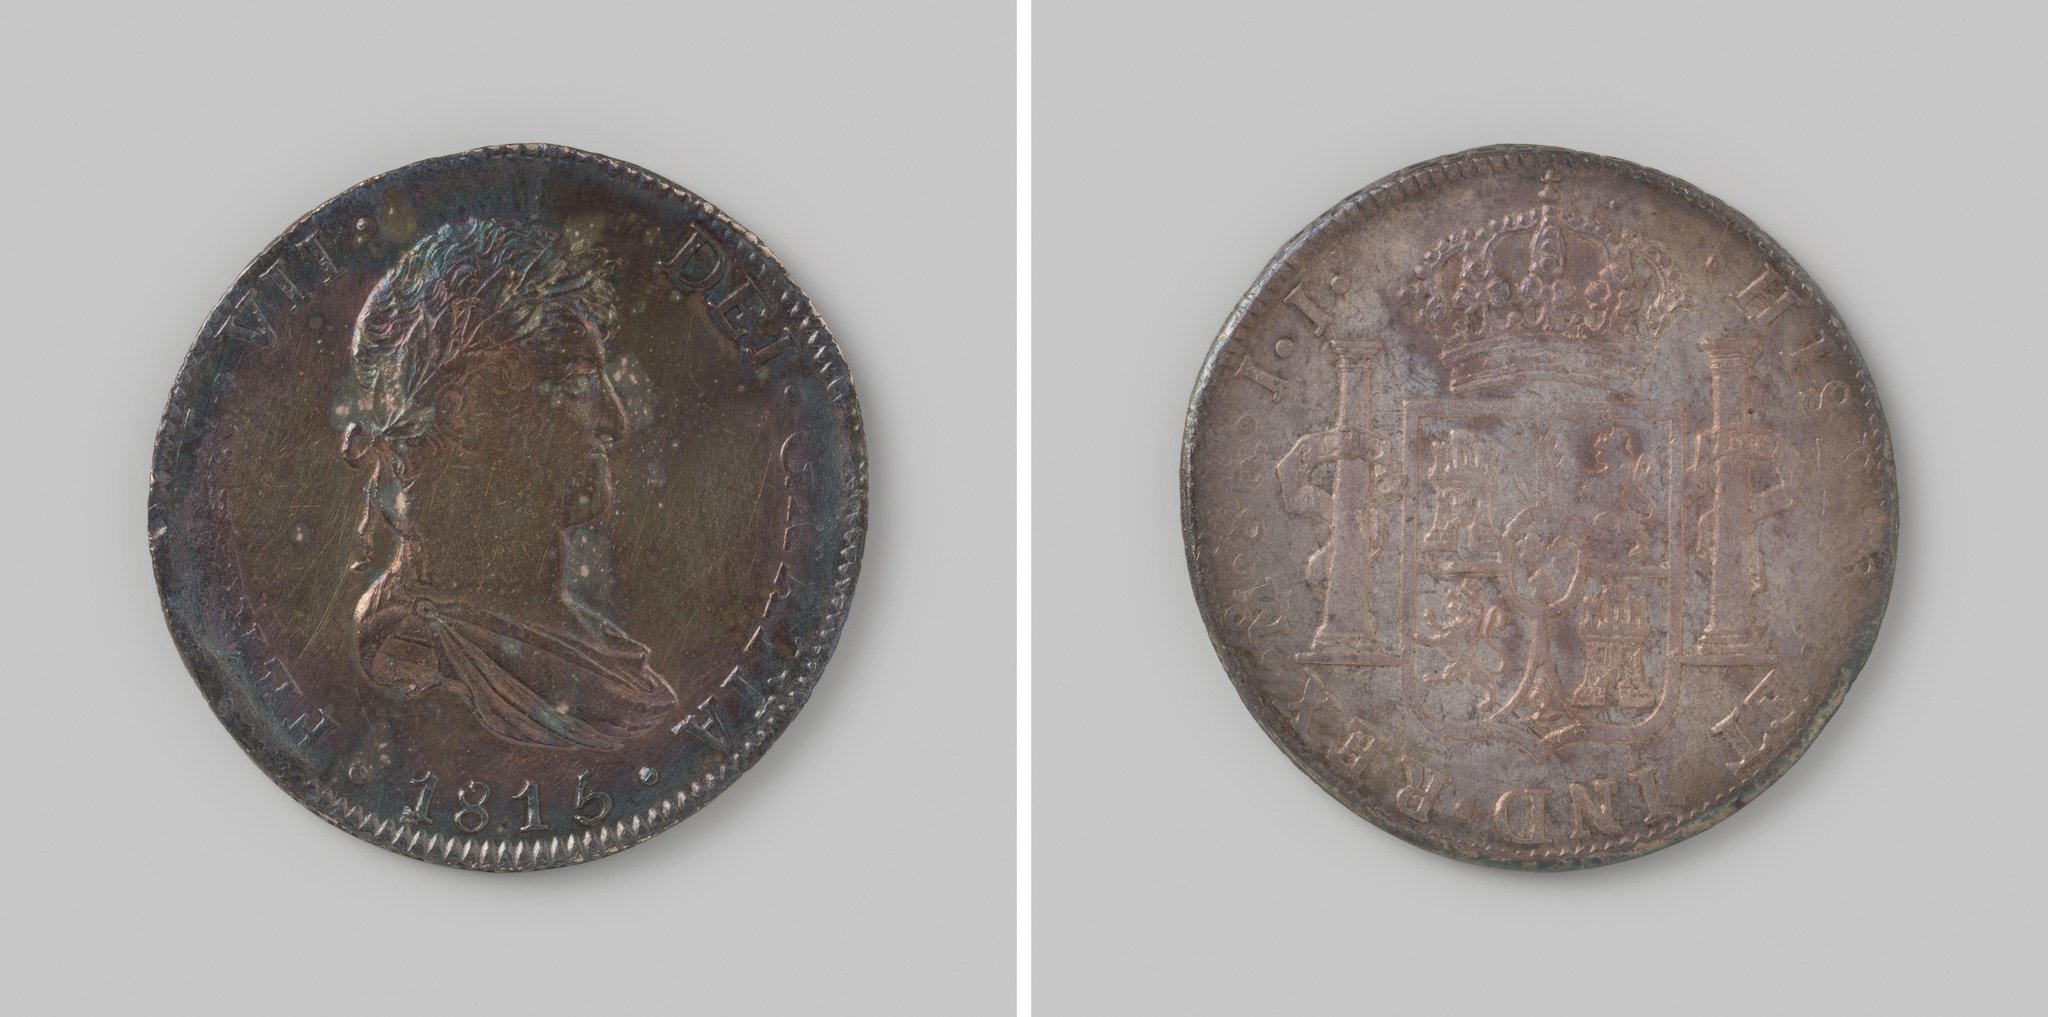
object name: coin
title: Peso of acht reaal uit Mexico van koning Ferdinand VII, 1815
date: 1815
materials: silver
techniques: striking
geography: mexico city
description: Zilveren munt. Voorzijde: gelauwerd hoofd van de koning naar rechts. Jaartal onderaan. Keerzijde: tussen twee uit zee oprijzende zuilen, waarop banderol met opschrift, gekroond samengesteld wapenschild. Muntplaats-aanduiding: Mo. en waarde-aanduiding: 8R in omschrift. Versierde rand.